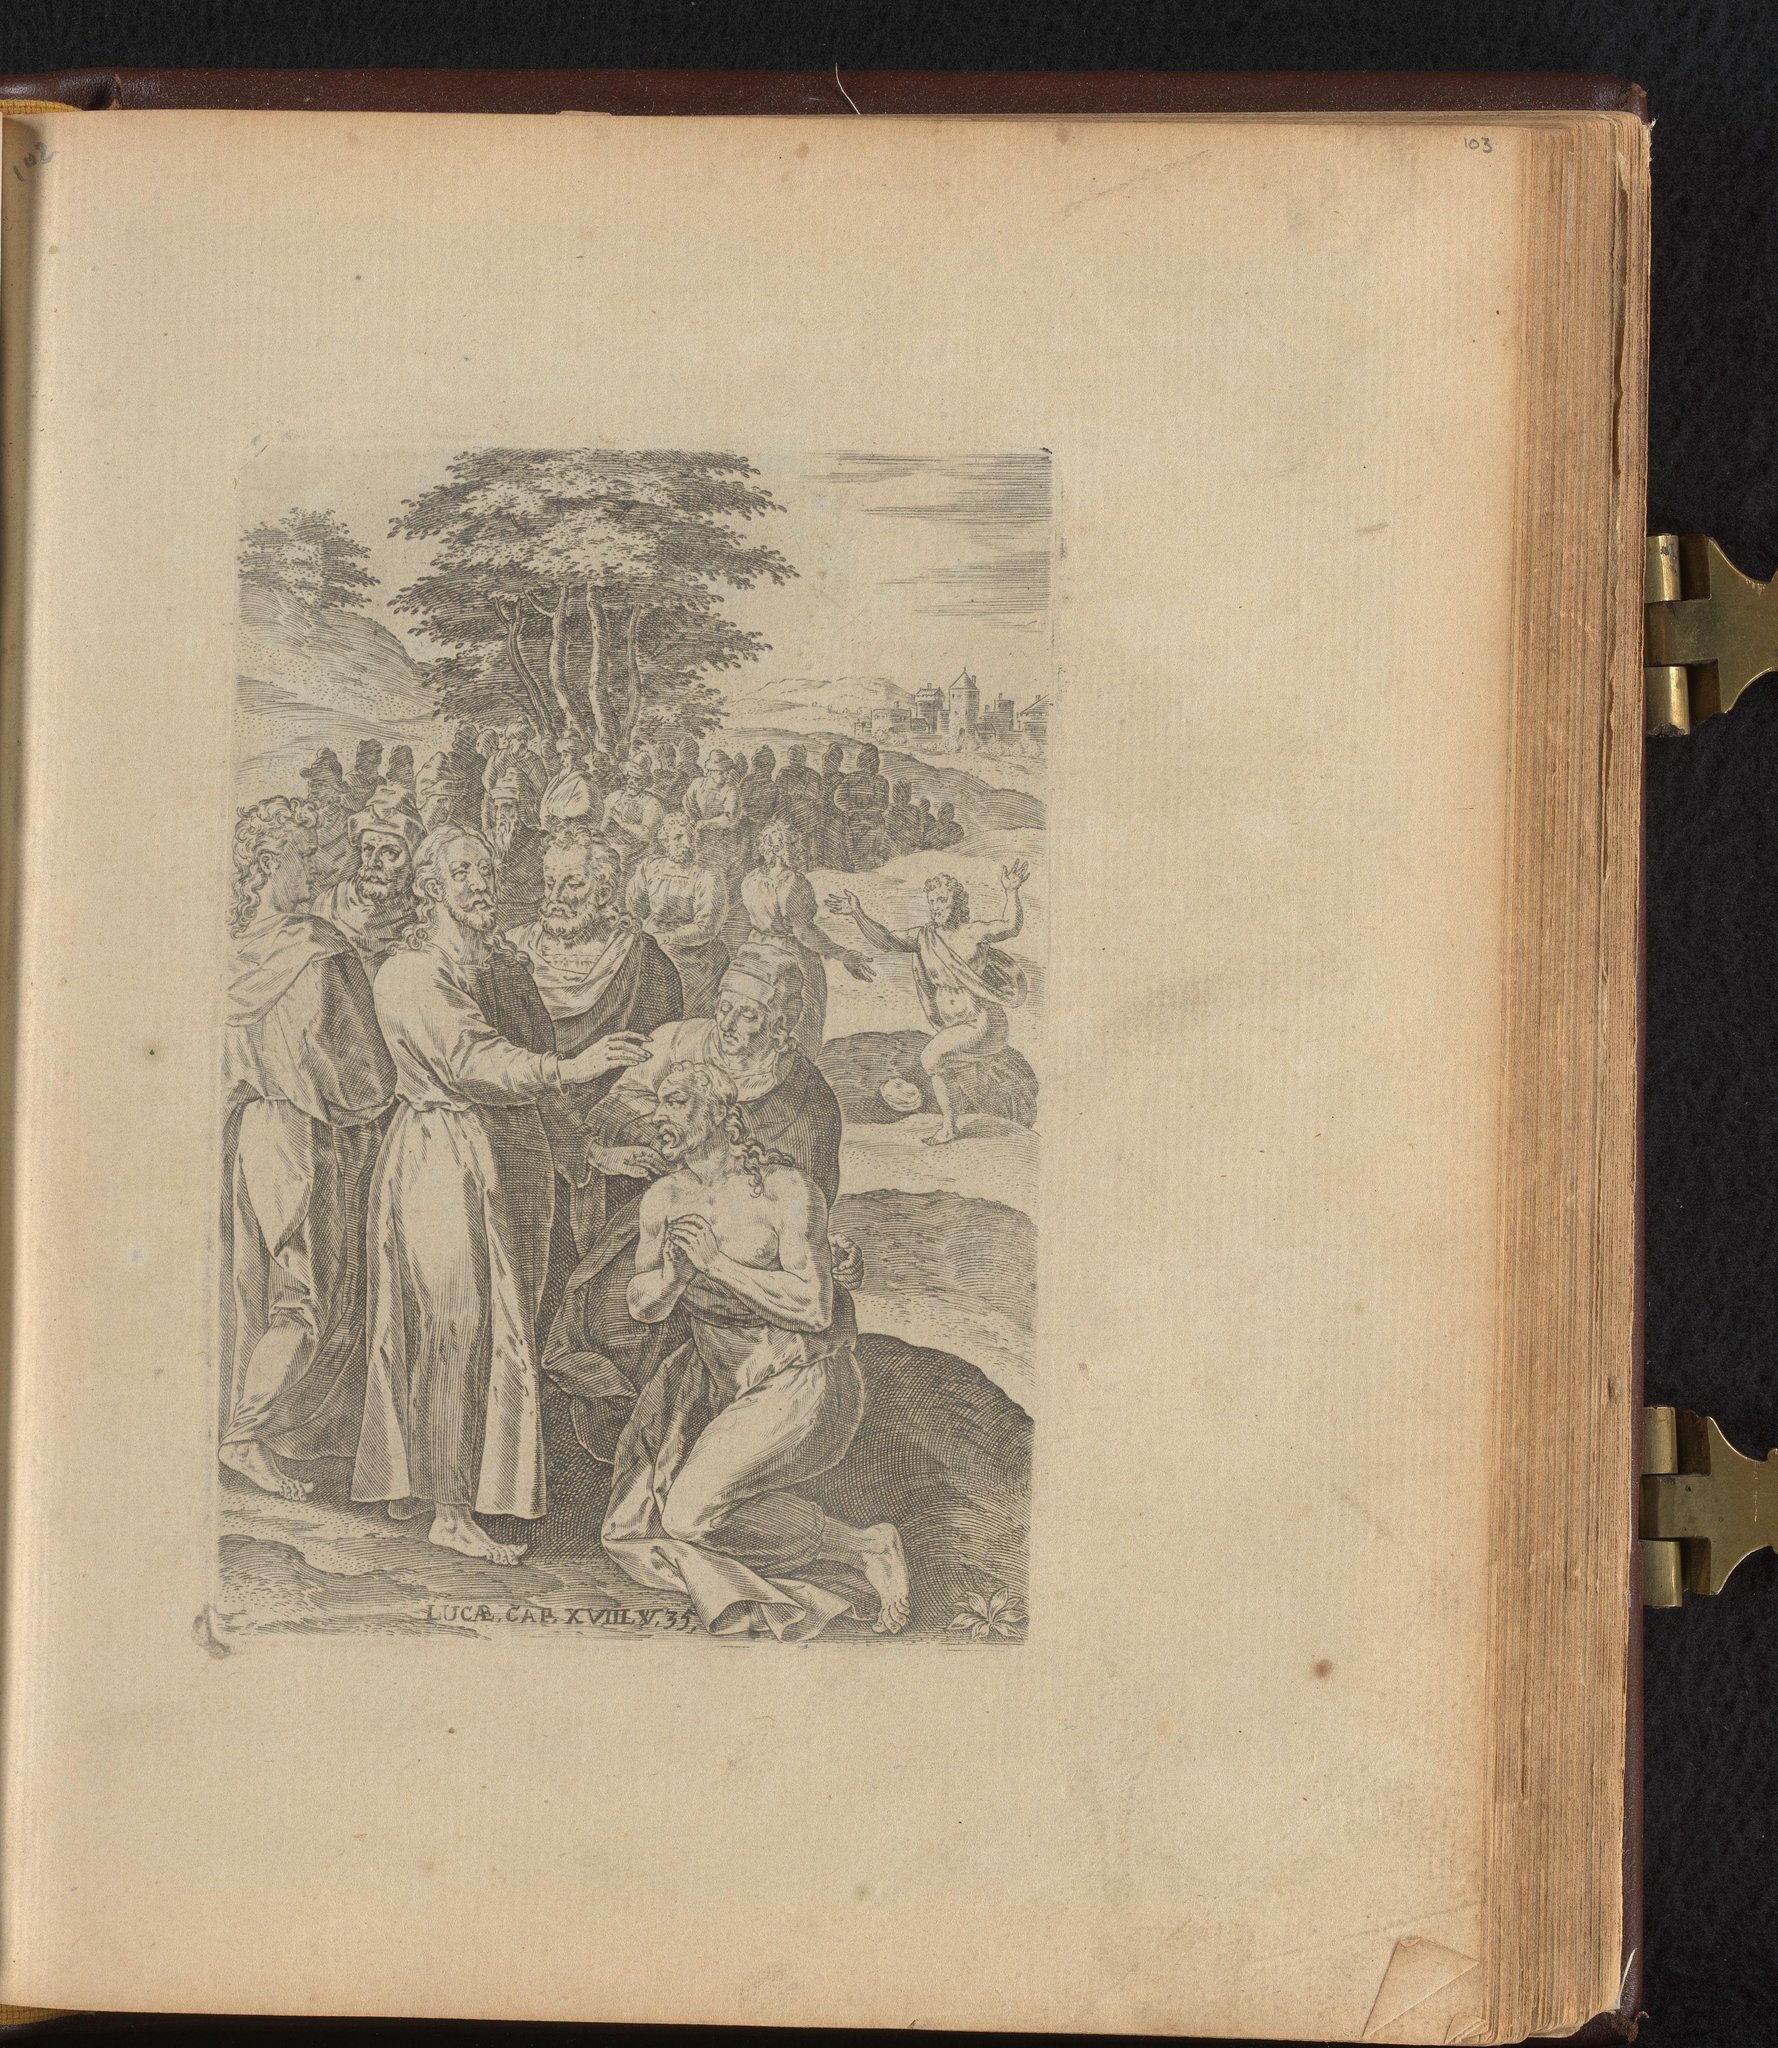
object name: album leaf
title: Christus geneest de blinde Bartimeus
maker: Anonymous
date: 1583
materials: paper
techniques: engraving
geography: southern netherlands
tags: healing of two blind men, or one (bartimaeus), sitting near jericho (matthew 20:29-34; mark 10:46-52; luke 18:35-43)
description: Eerdere staat van prent gebruikt als boekillustratie in: Biblia Sacra. Antwerpen: Christoffel Plantijn, 1583.